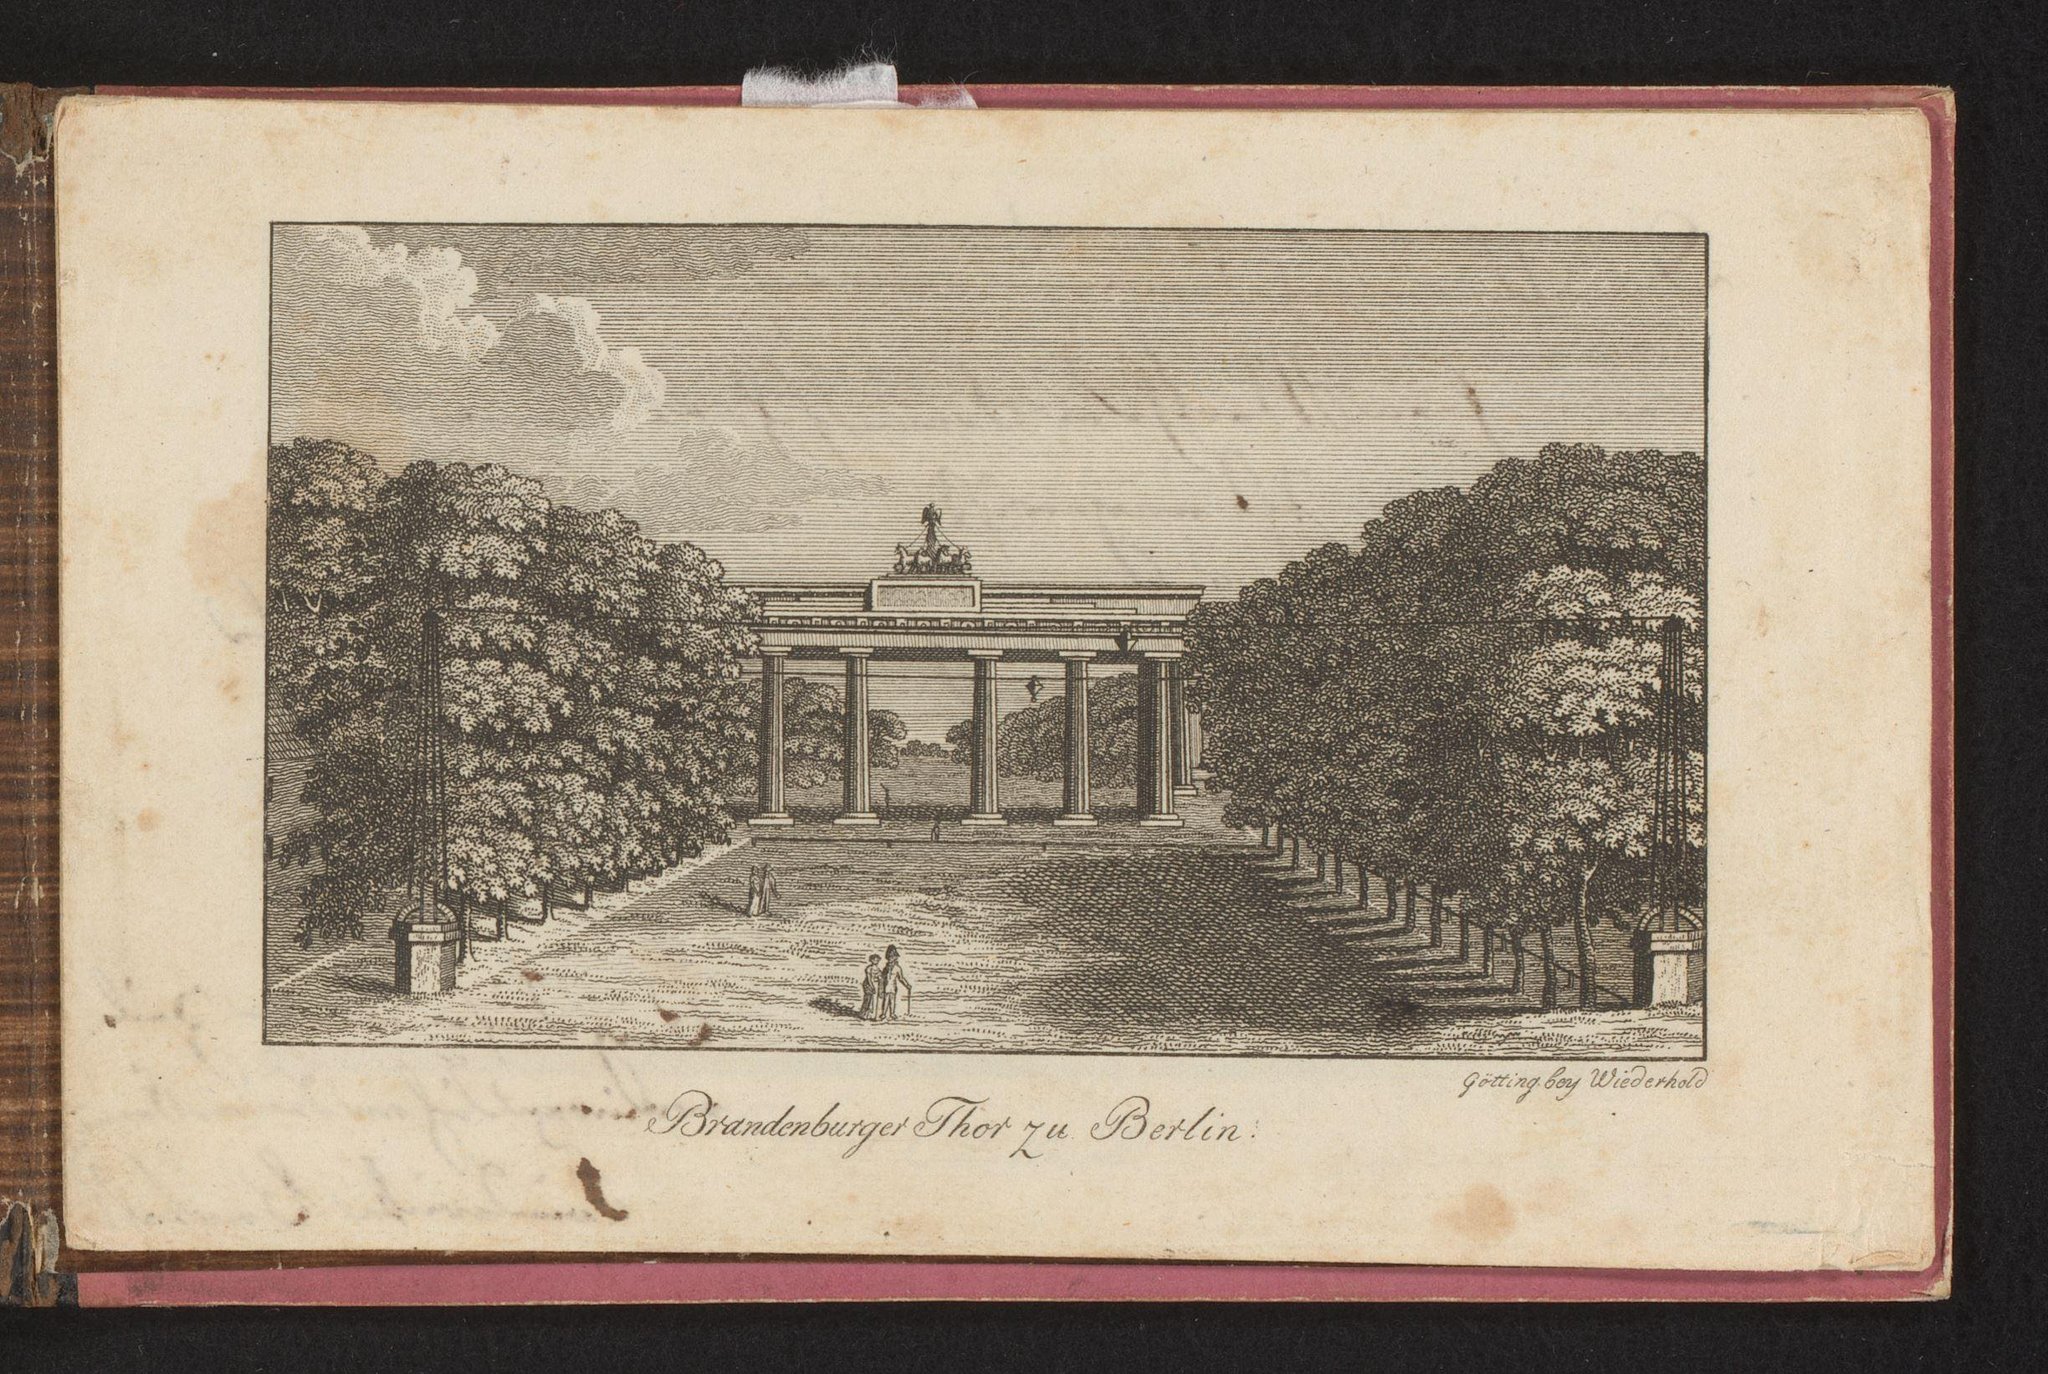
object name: print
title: Brandenburger Thor zu Berlin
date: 1770-1826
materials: ink, paper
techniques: etching, writing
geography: gottingen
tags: 'album amicorum', 'stammbuch', triumphal arch, gate, entrance, berlin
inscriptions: tekst, verso, handgeschreven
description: Handgeschreven tekst in het Duits op het verso.